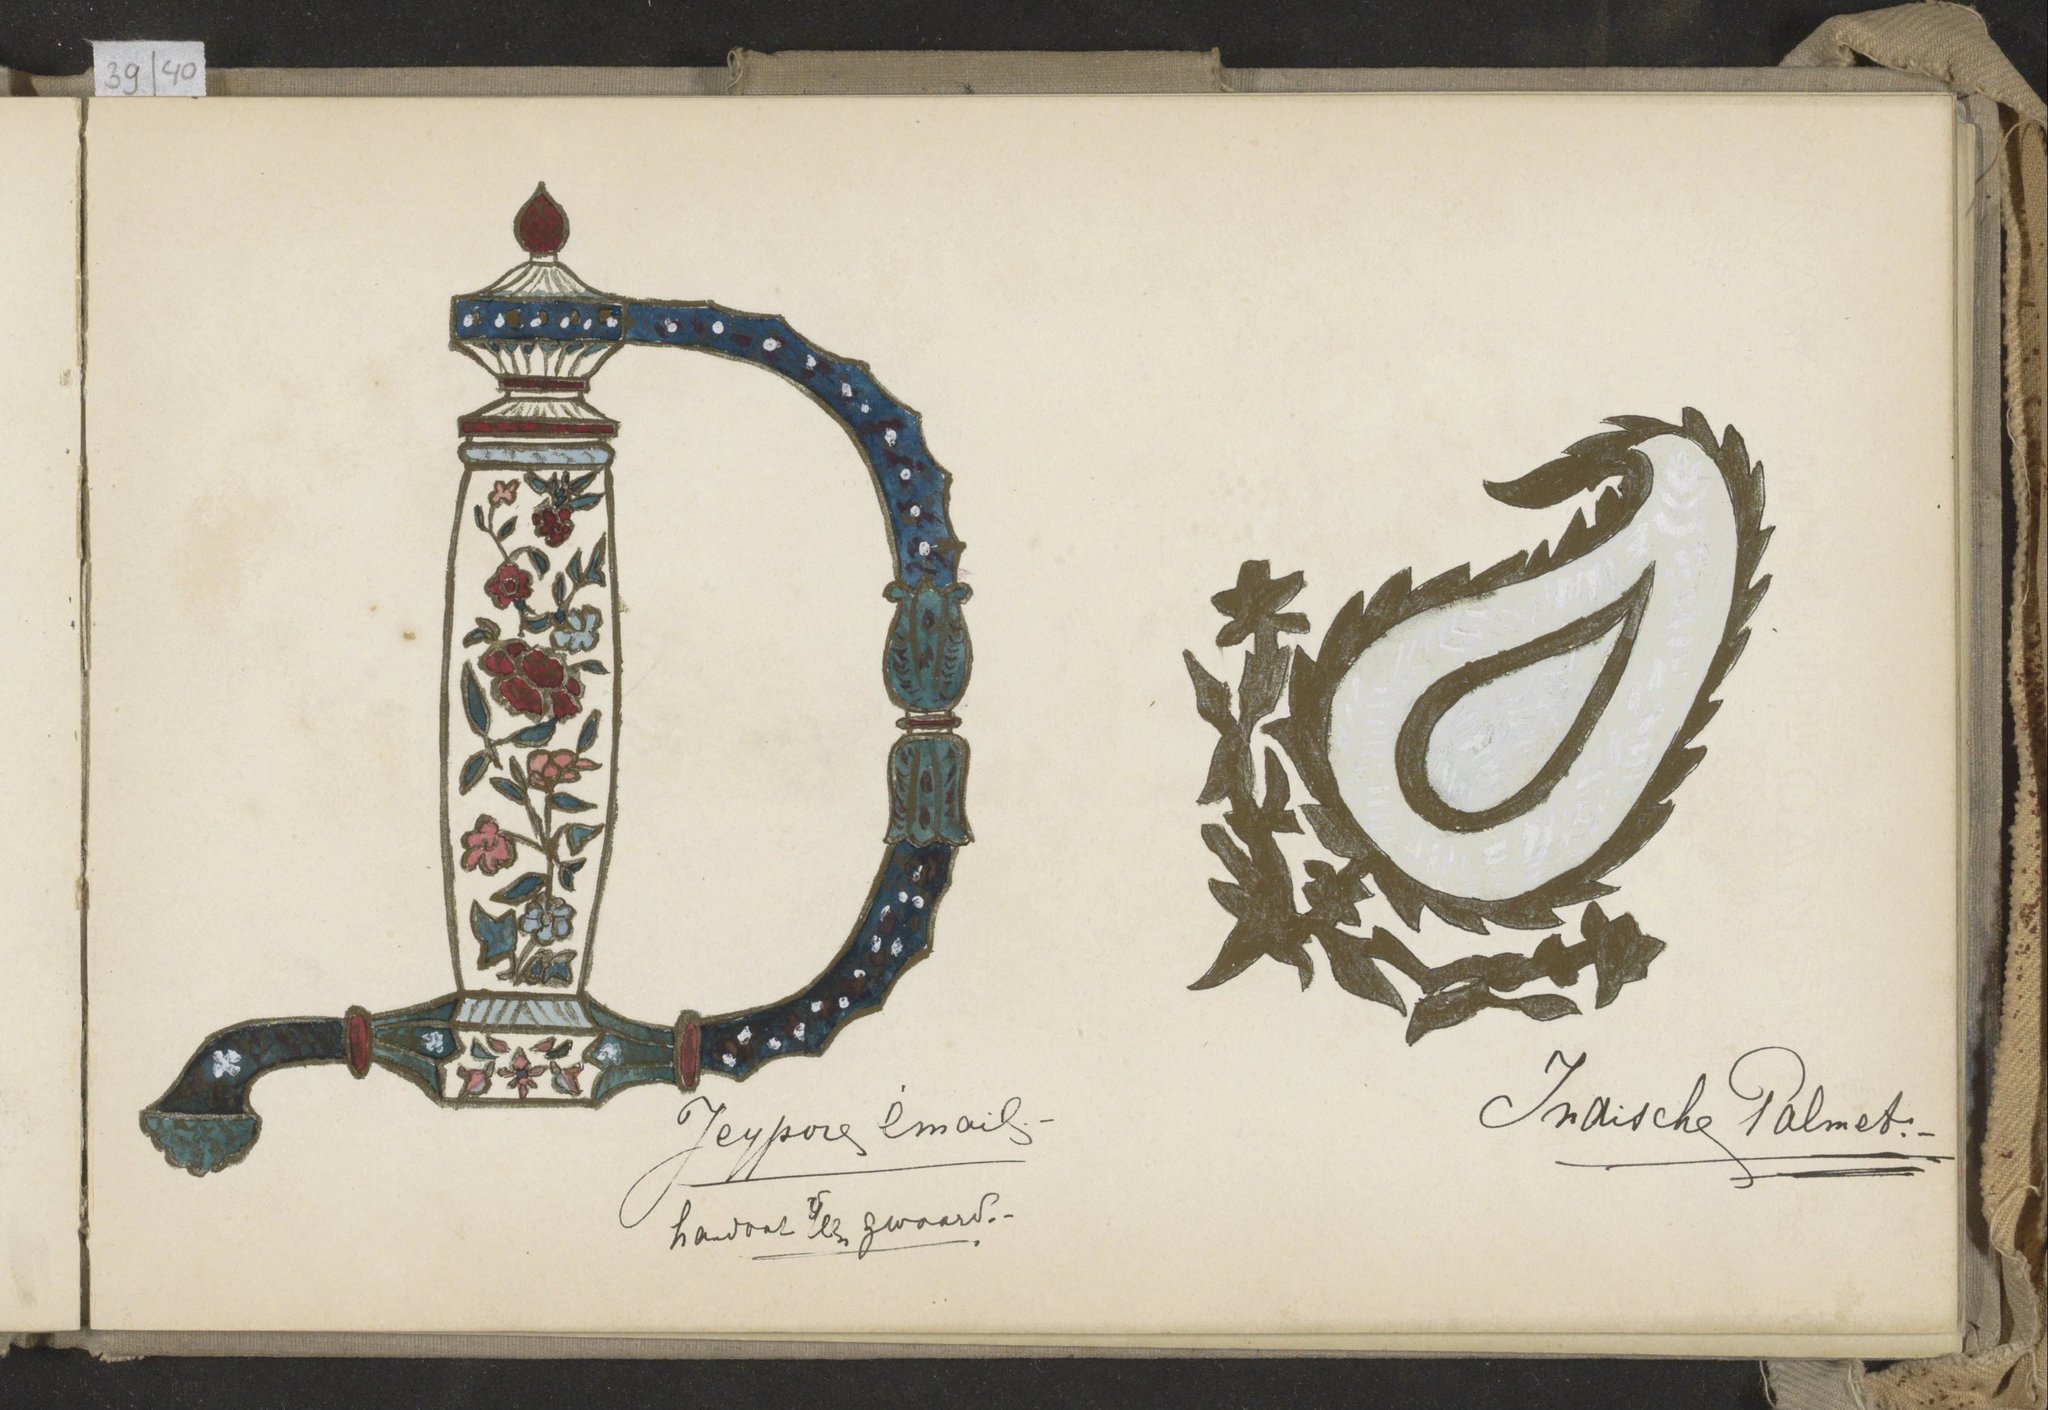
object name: sketchbook leaf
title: Heft van een zwaard uit Jaipur en een Indisch palmet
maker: johanna van de kamer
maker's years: 1873-1922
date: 1890-1922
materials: paint, ink, paper, pencil, watercolor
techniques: brush, pen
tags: palmette ~ ornament, parts of hacking and thrusting weapons: grip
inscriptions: annotation: ‘Jeypore email.-/ handvat v/een zwaard.-/ Indisch palmet.-’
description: Blad 37 recto uit een schetsboek met 49 bladen.